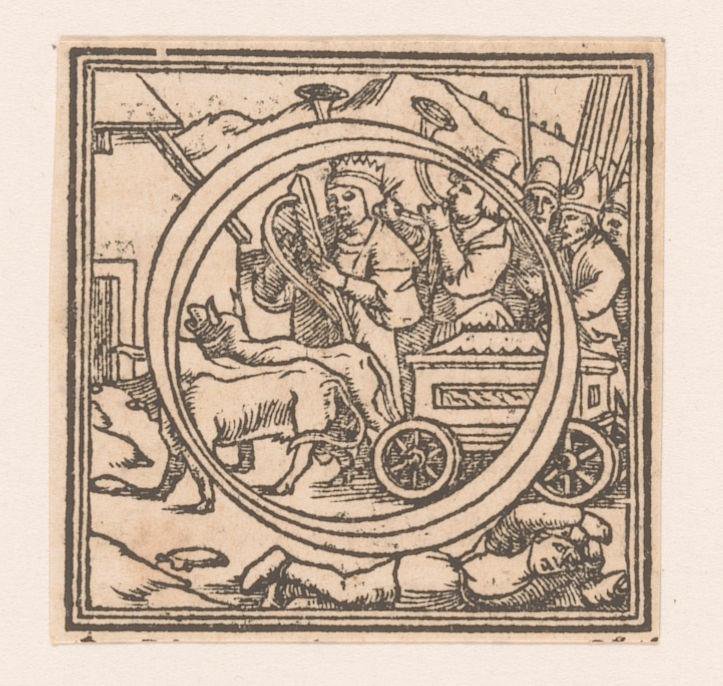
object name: print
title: Versierde initialen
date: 1556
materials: paper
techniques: letterpress printing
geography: zurich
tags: initial, david's triumph, but david without the head of goliath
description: Prent afkomstig uit: Bibel, die gantze, das ist alle Bücher alts und news Testaments (...). Zürich: Johann Froschauer, 1556.